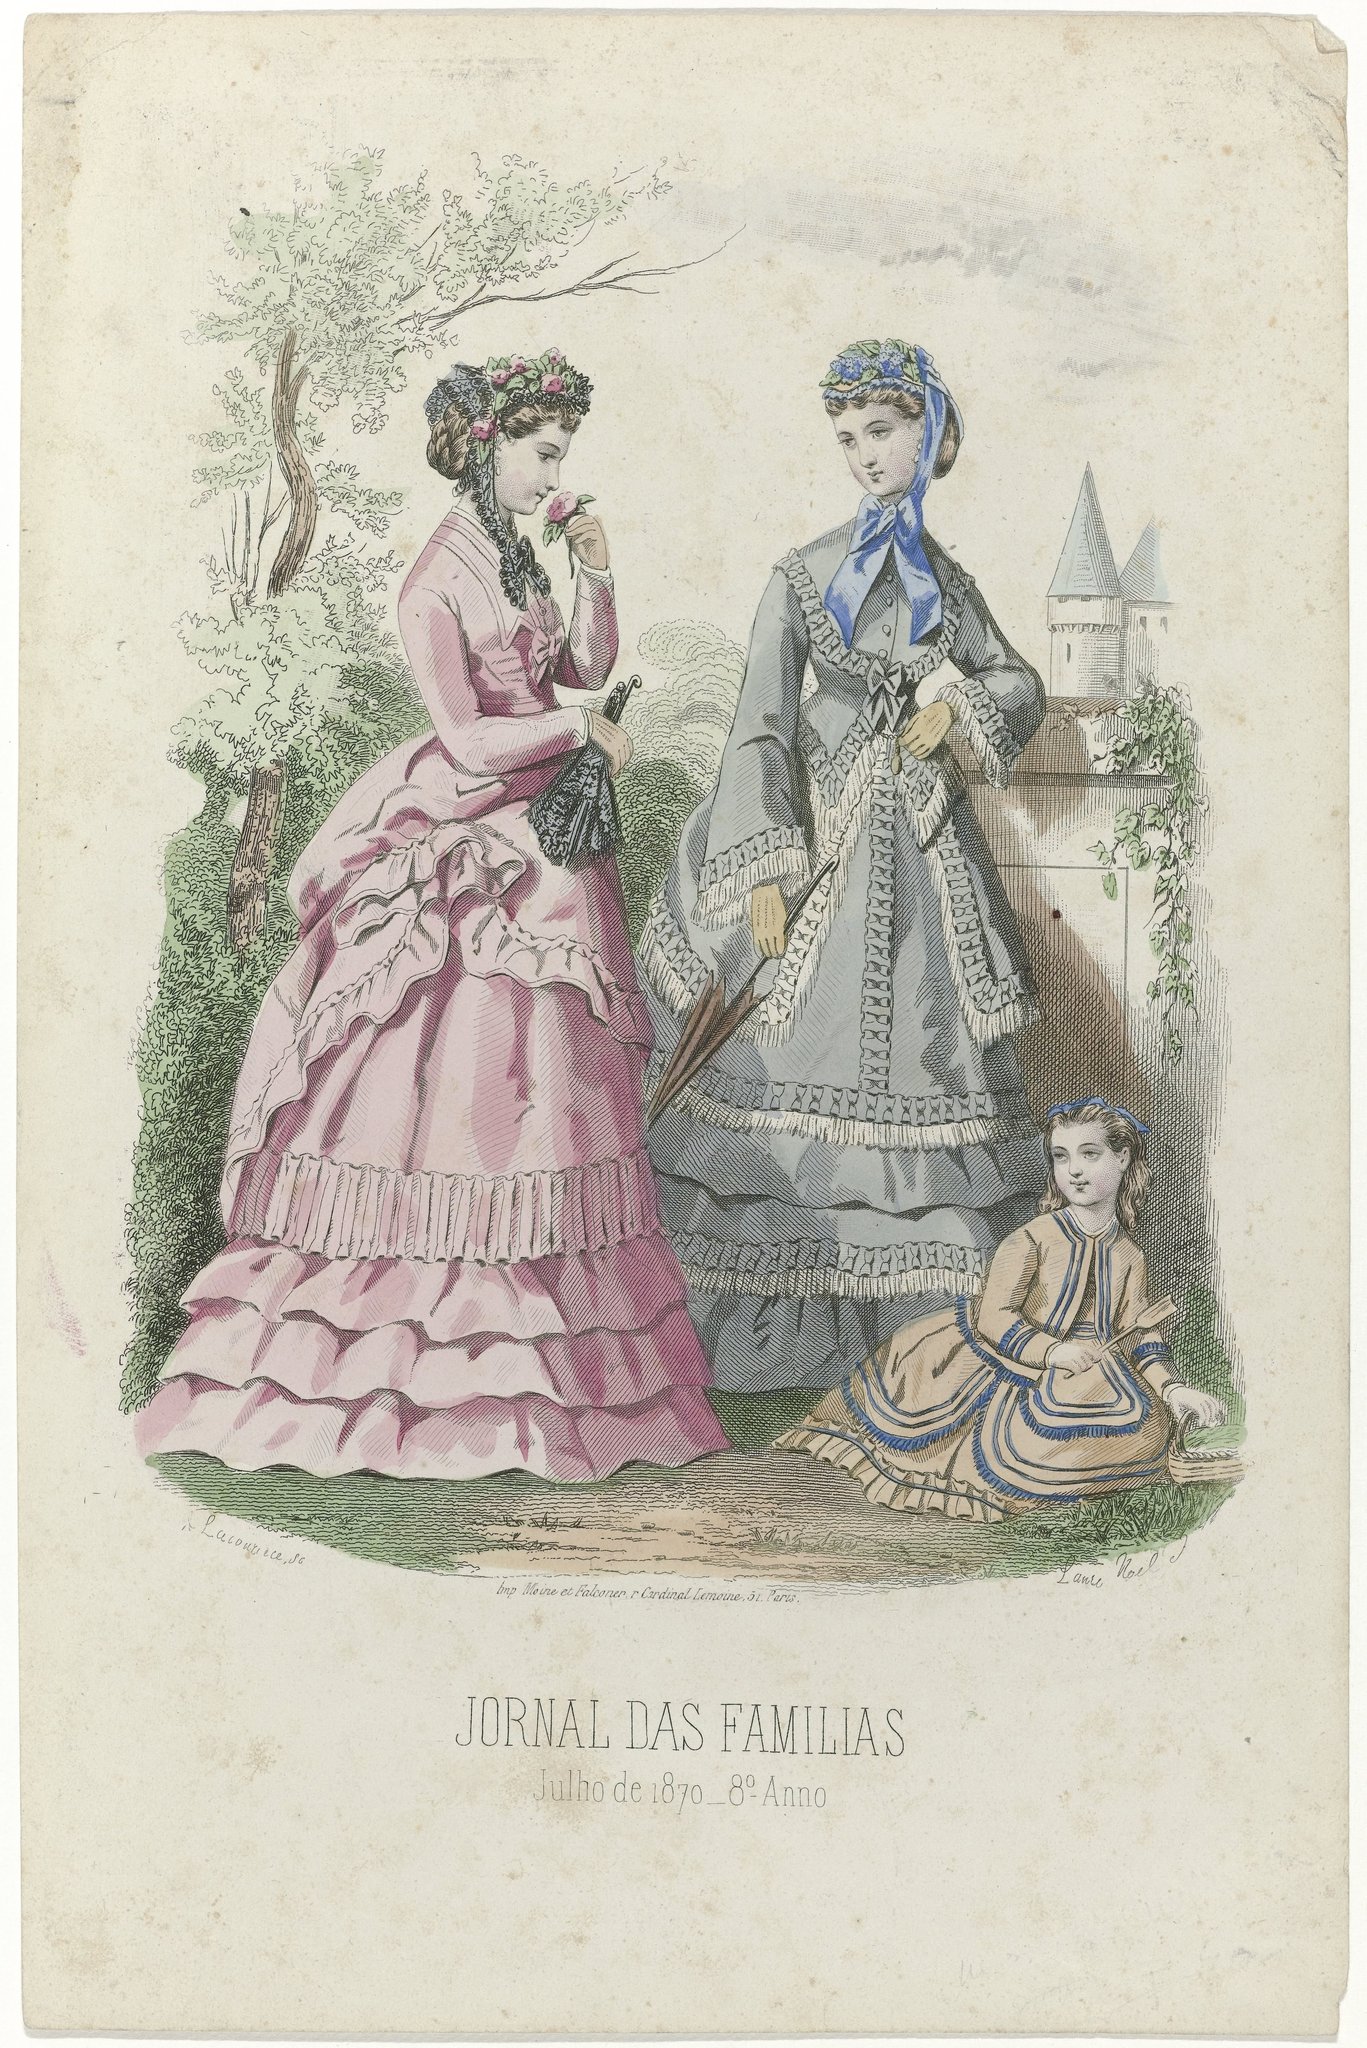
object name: fashion print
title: Jornal das Familias, Julho (juli) 1870, 8o Anno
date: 1870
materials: paper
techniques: engraving, etching, hand coloring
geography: paris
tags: cut flowers; nosegay, bunch of flowers, coat (+ girls' clothes), head-gear (+ women's clothes), fashion plates, gloves, mittens, etc. (+ women's clothes), dress, gown (+ women's clothes), parasol, sunshade (+ women's clothes), dress, gown (+ girls' clothes)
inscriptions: title: ‘Jornal das Familias’